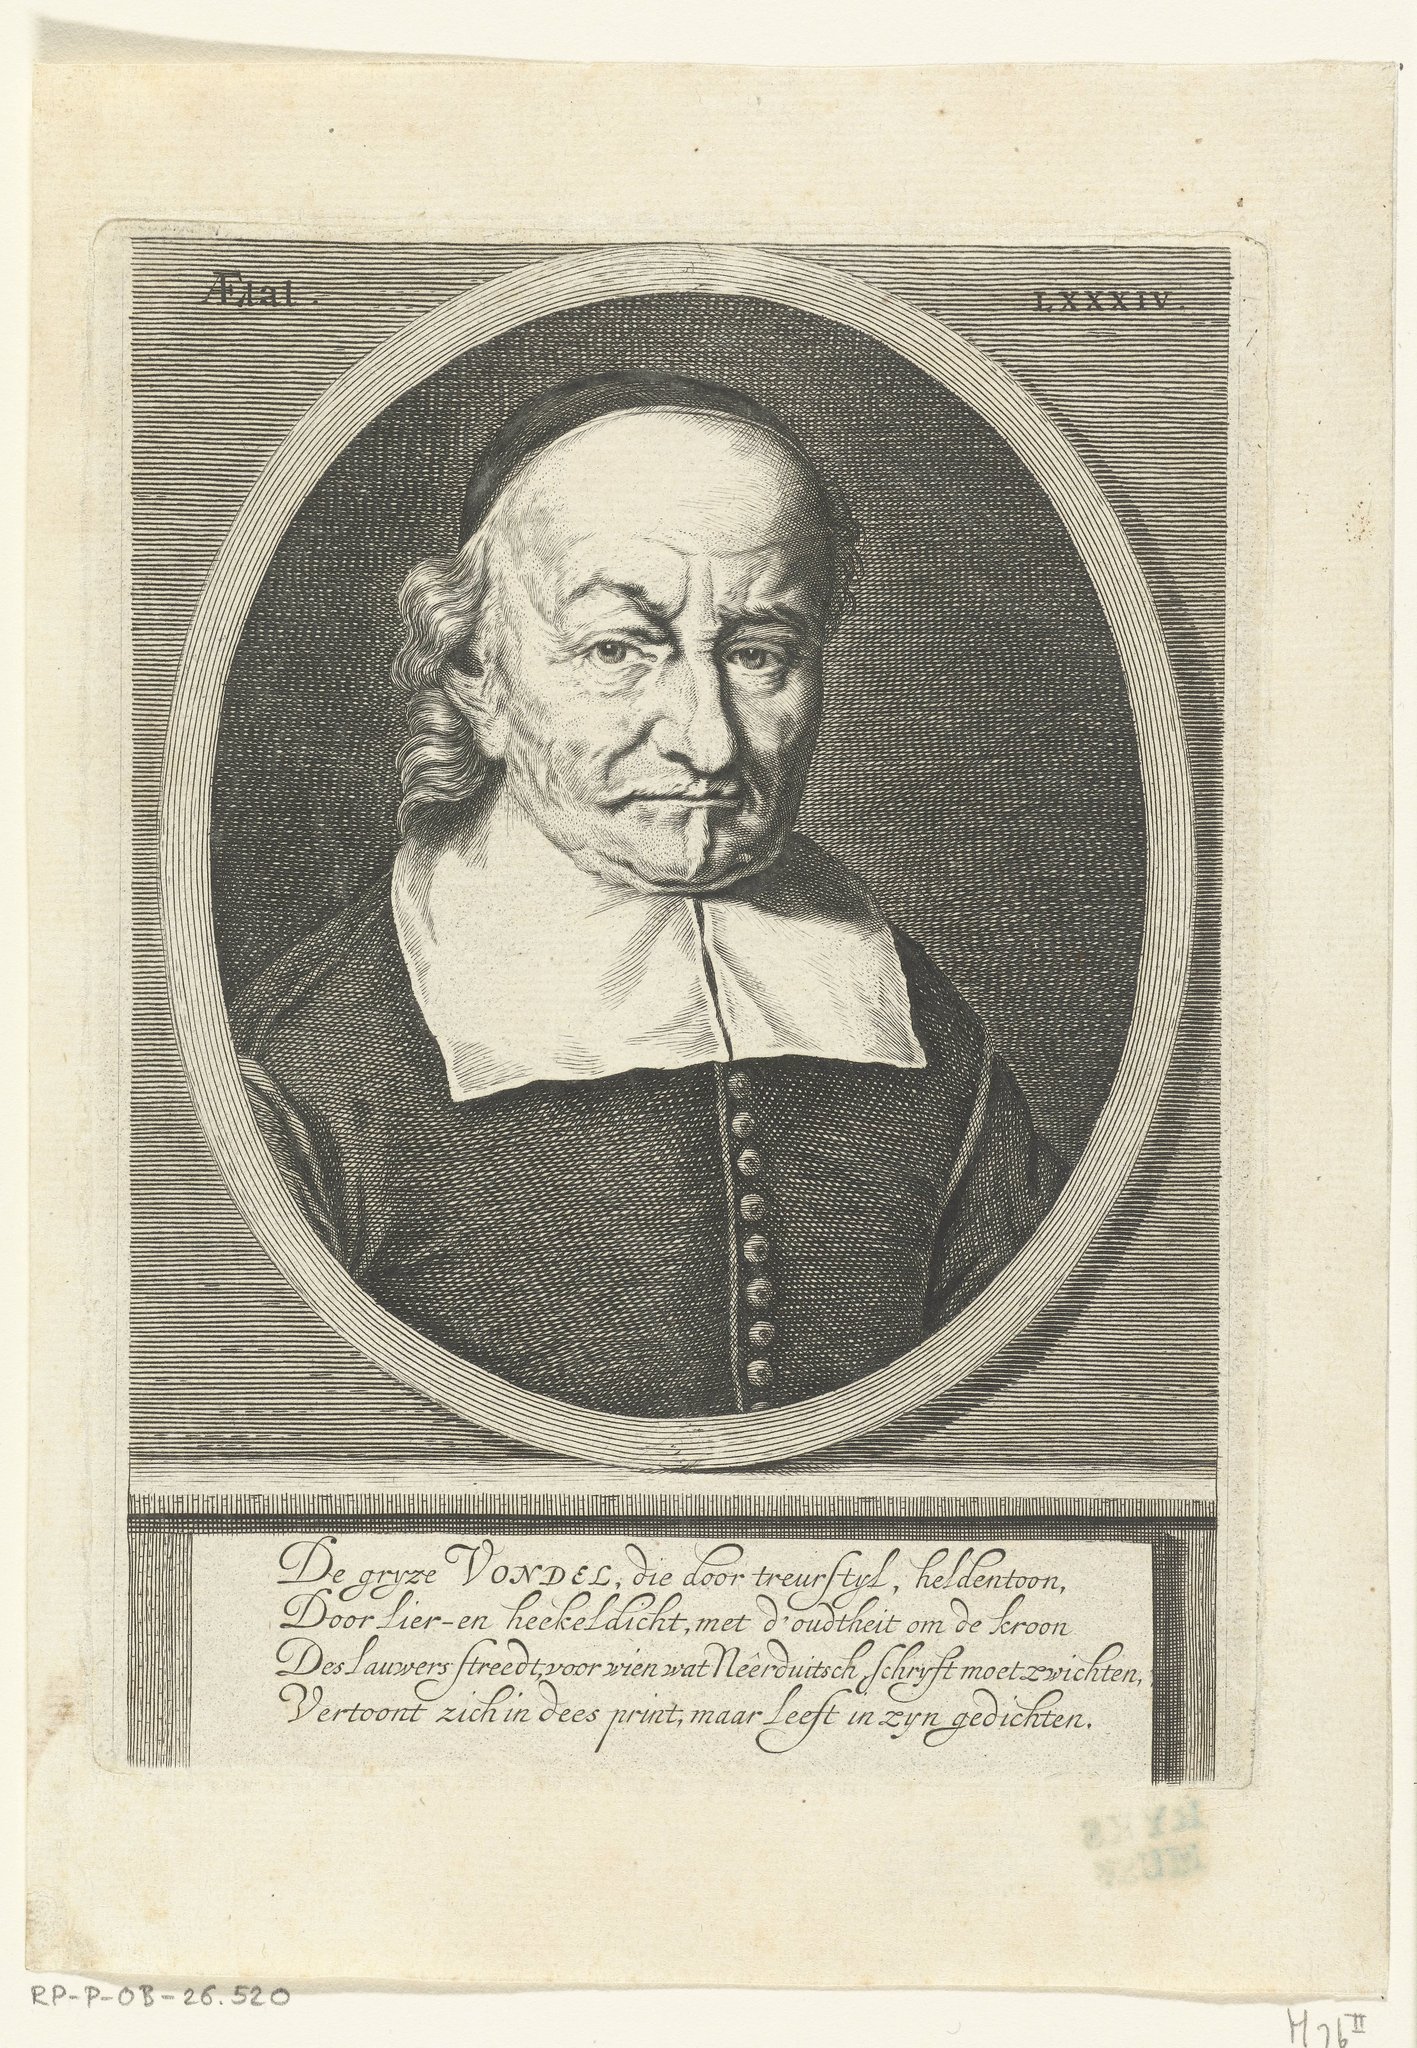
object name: print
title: Portret van Joost van den Vondel op 84-jarige leeftijd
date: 1657-1707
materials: paper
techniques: engraving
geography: netherlands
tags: cologne, amsterdam, joost van den vondel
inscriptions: collector's mark: Lugt 2228, collector's mark: Lugt 2165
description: Portret van Joost van den Vondel op 84-jarige leeftijd. Onder het portret een vers van vier regels in het Nederlands door G. Brandt.